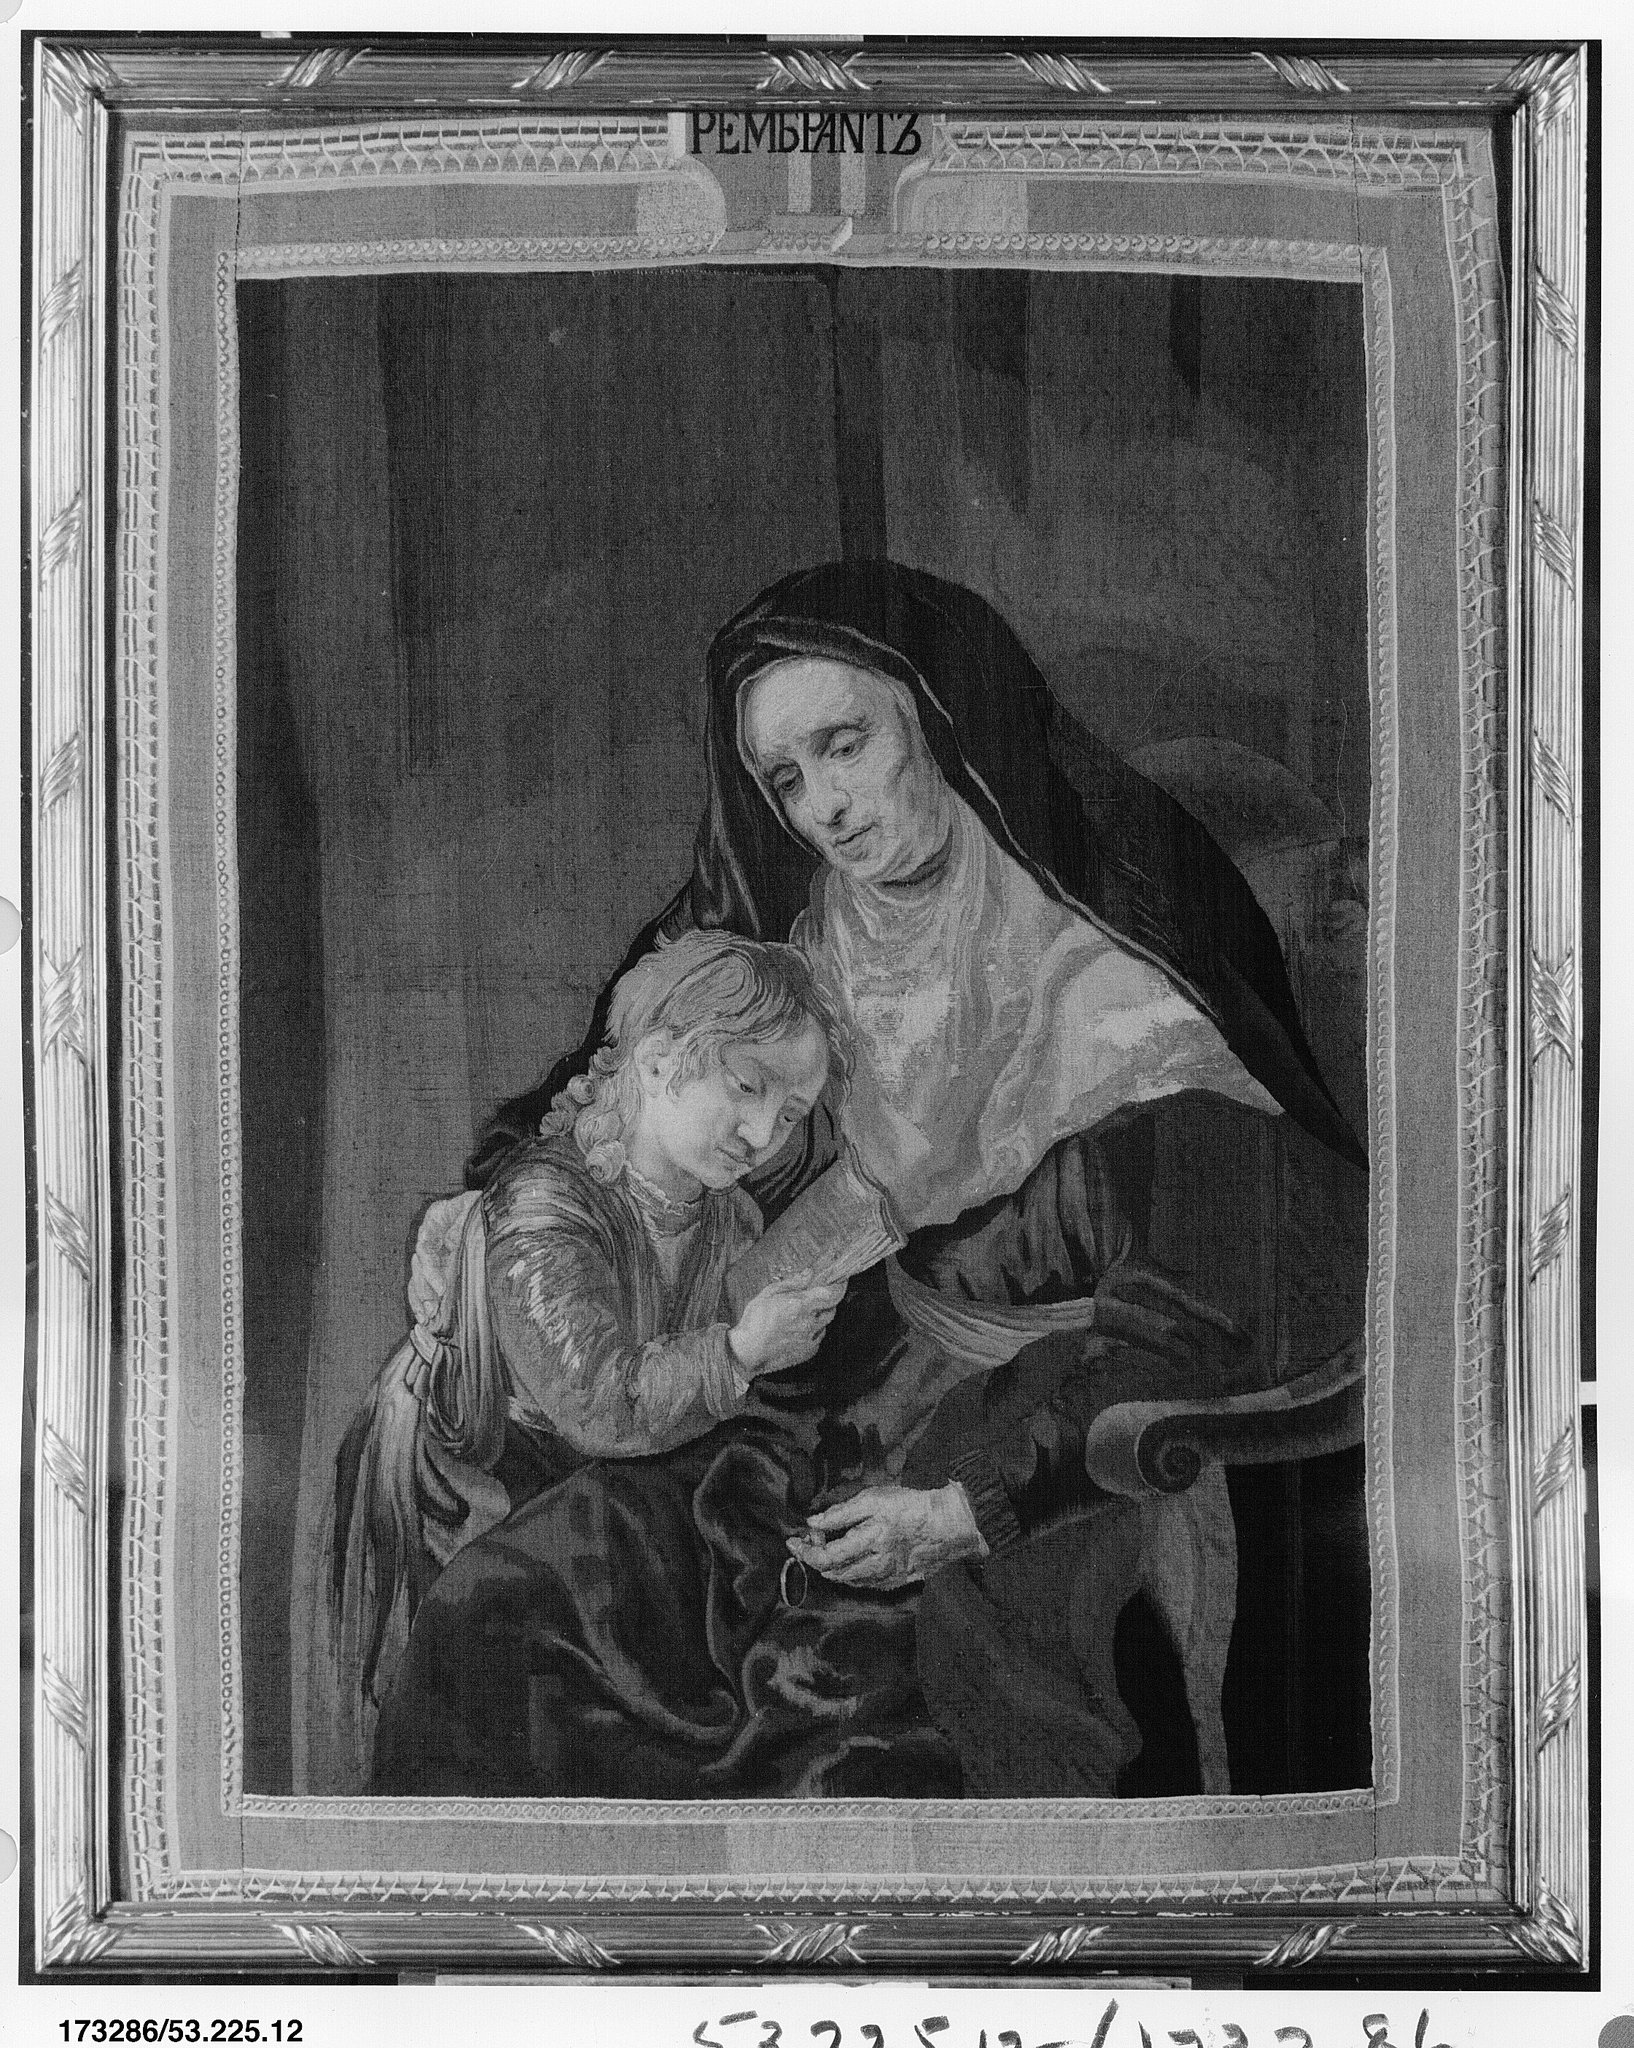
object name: tapestry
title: Hannah and the Infant Samuel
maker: imperial russian tapestry manufactory, saint petersburg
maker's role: manufactory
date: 1767-1800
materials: metal thread, wool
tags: infants,women,reading